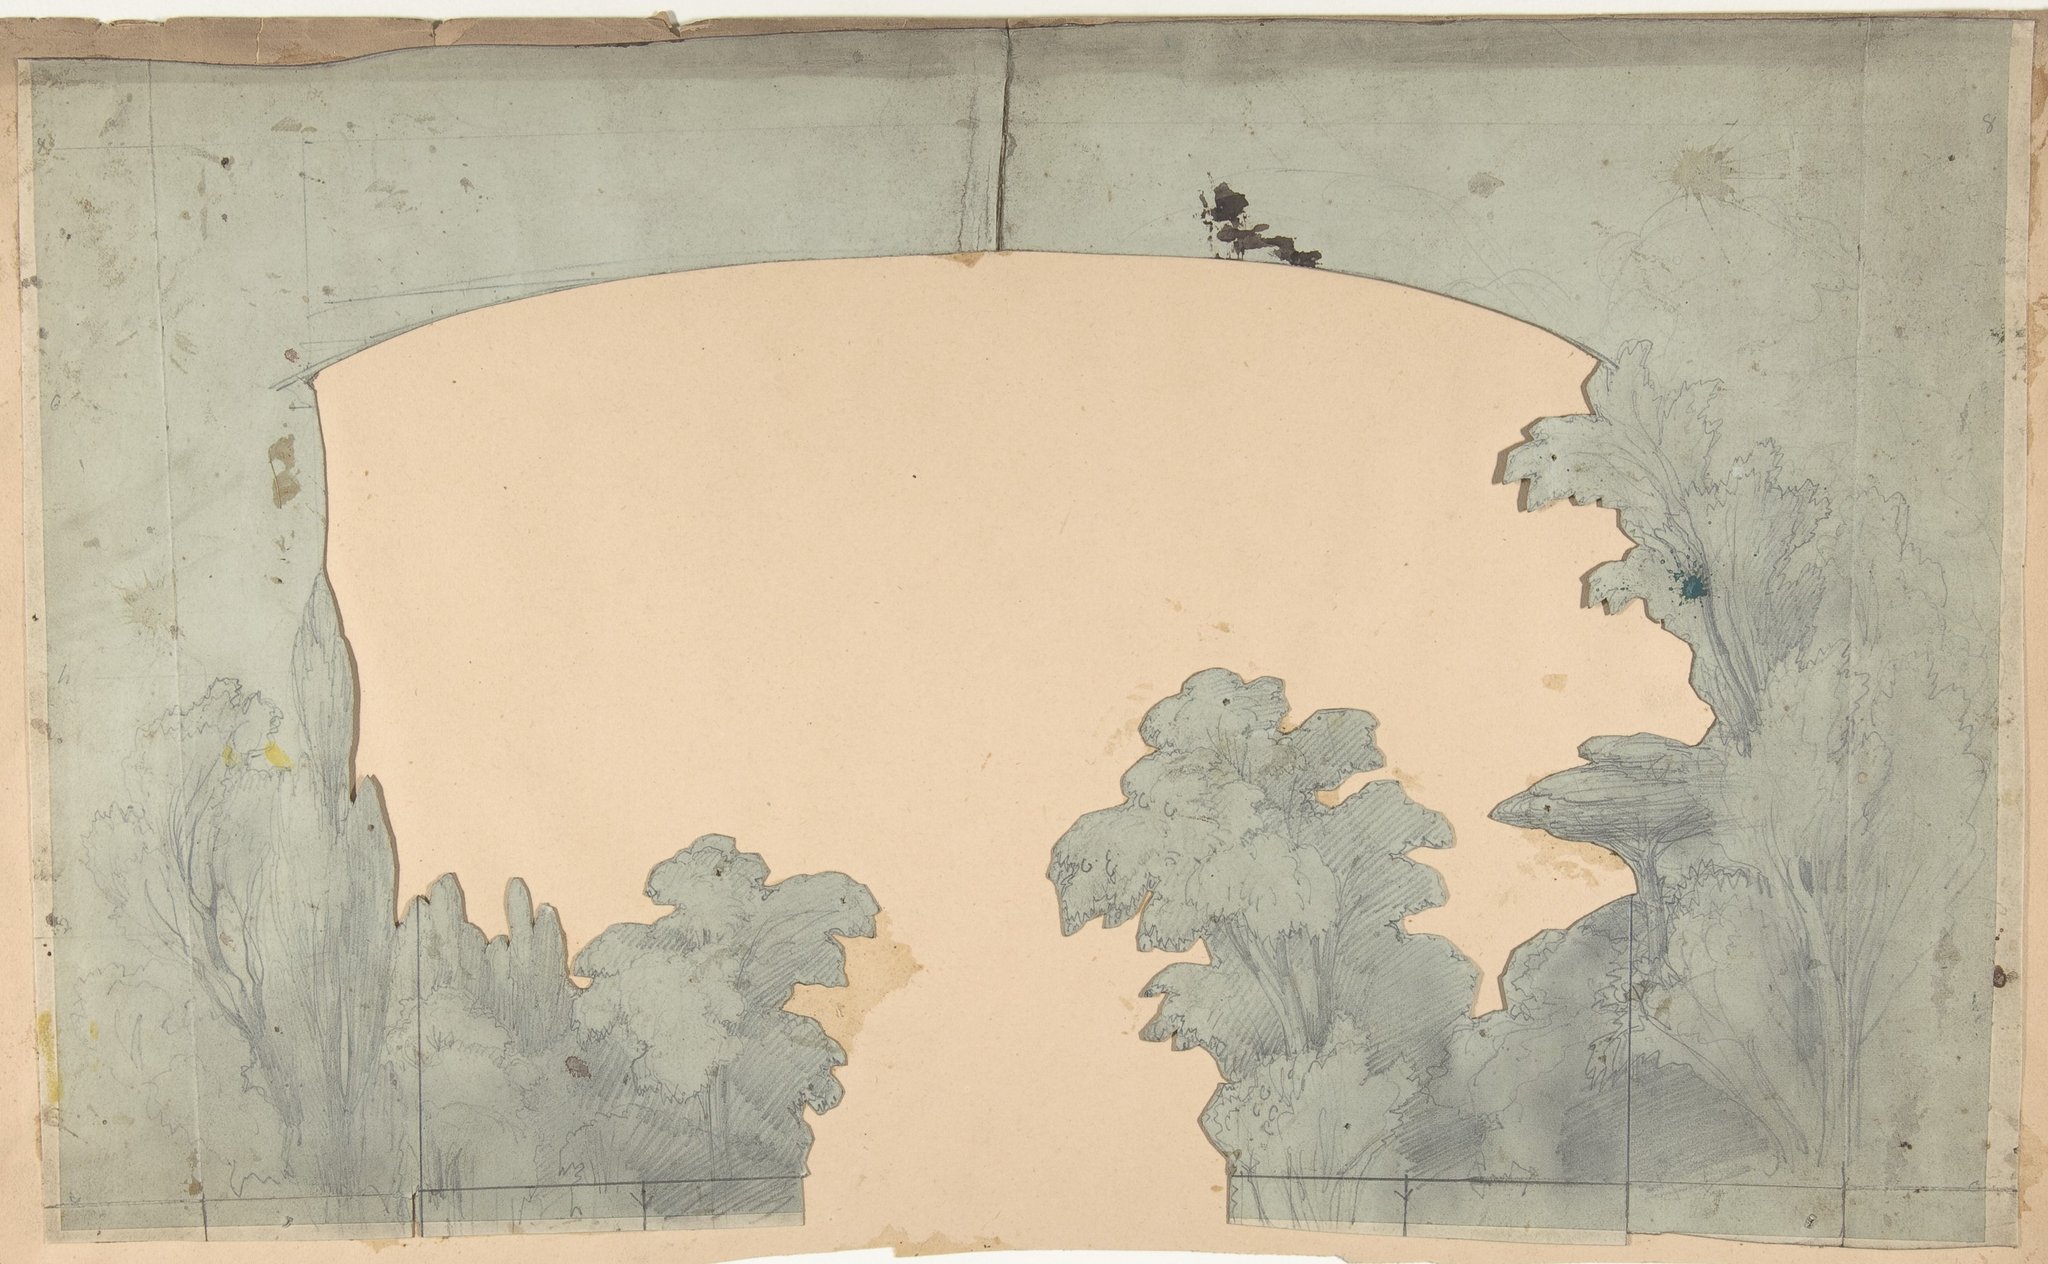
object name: drawing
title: Design for a Stage Set at the Opéra, Paris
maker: eugène cicéri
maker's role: artist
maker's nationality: french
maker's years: 1813-1890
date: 1830-1890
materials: graphite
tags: trees,stage design